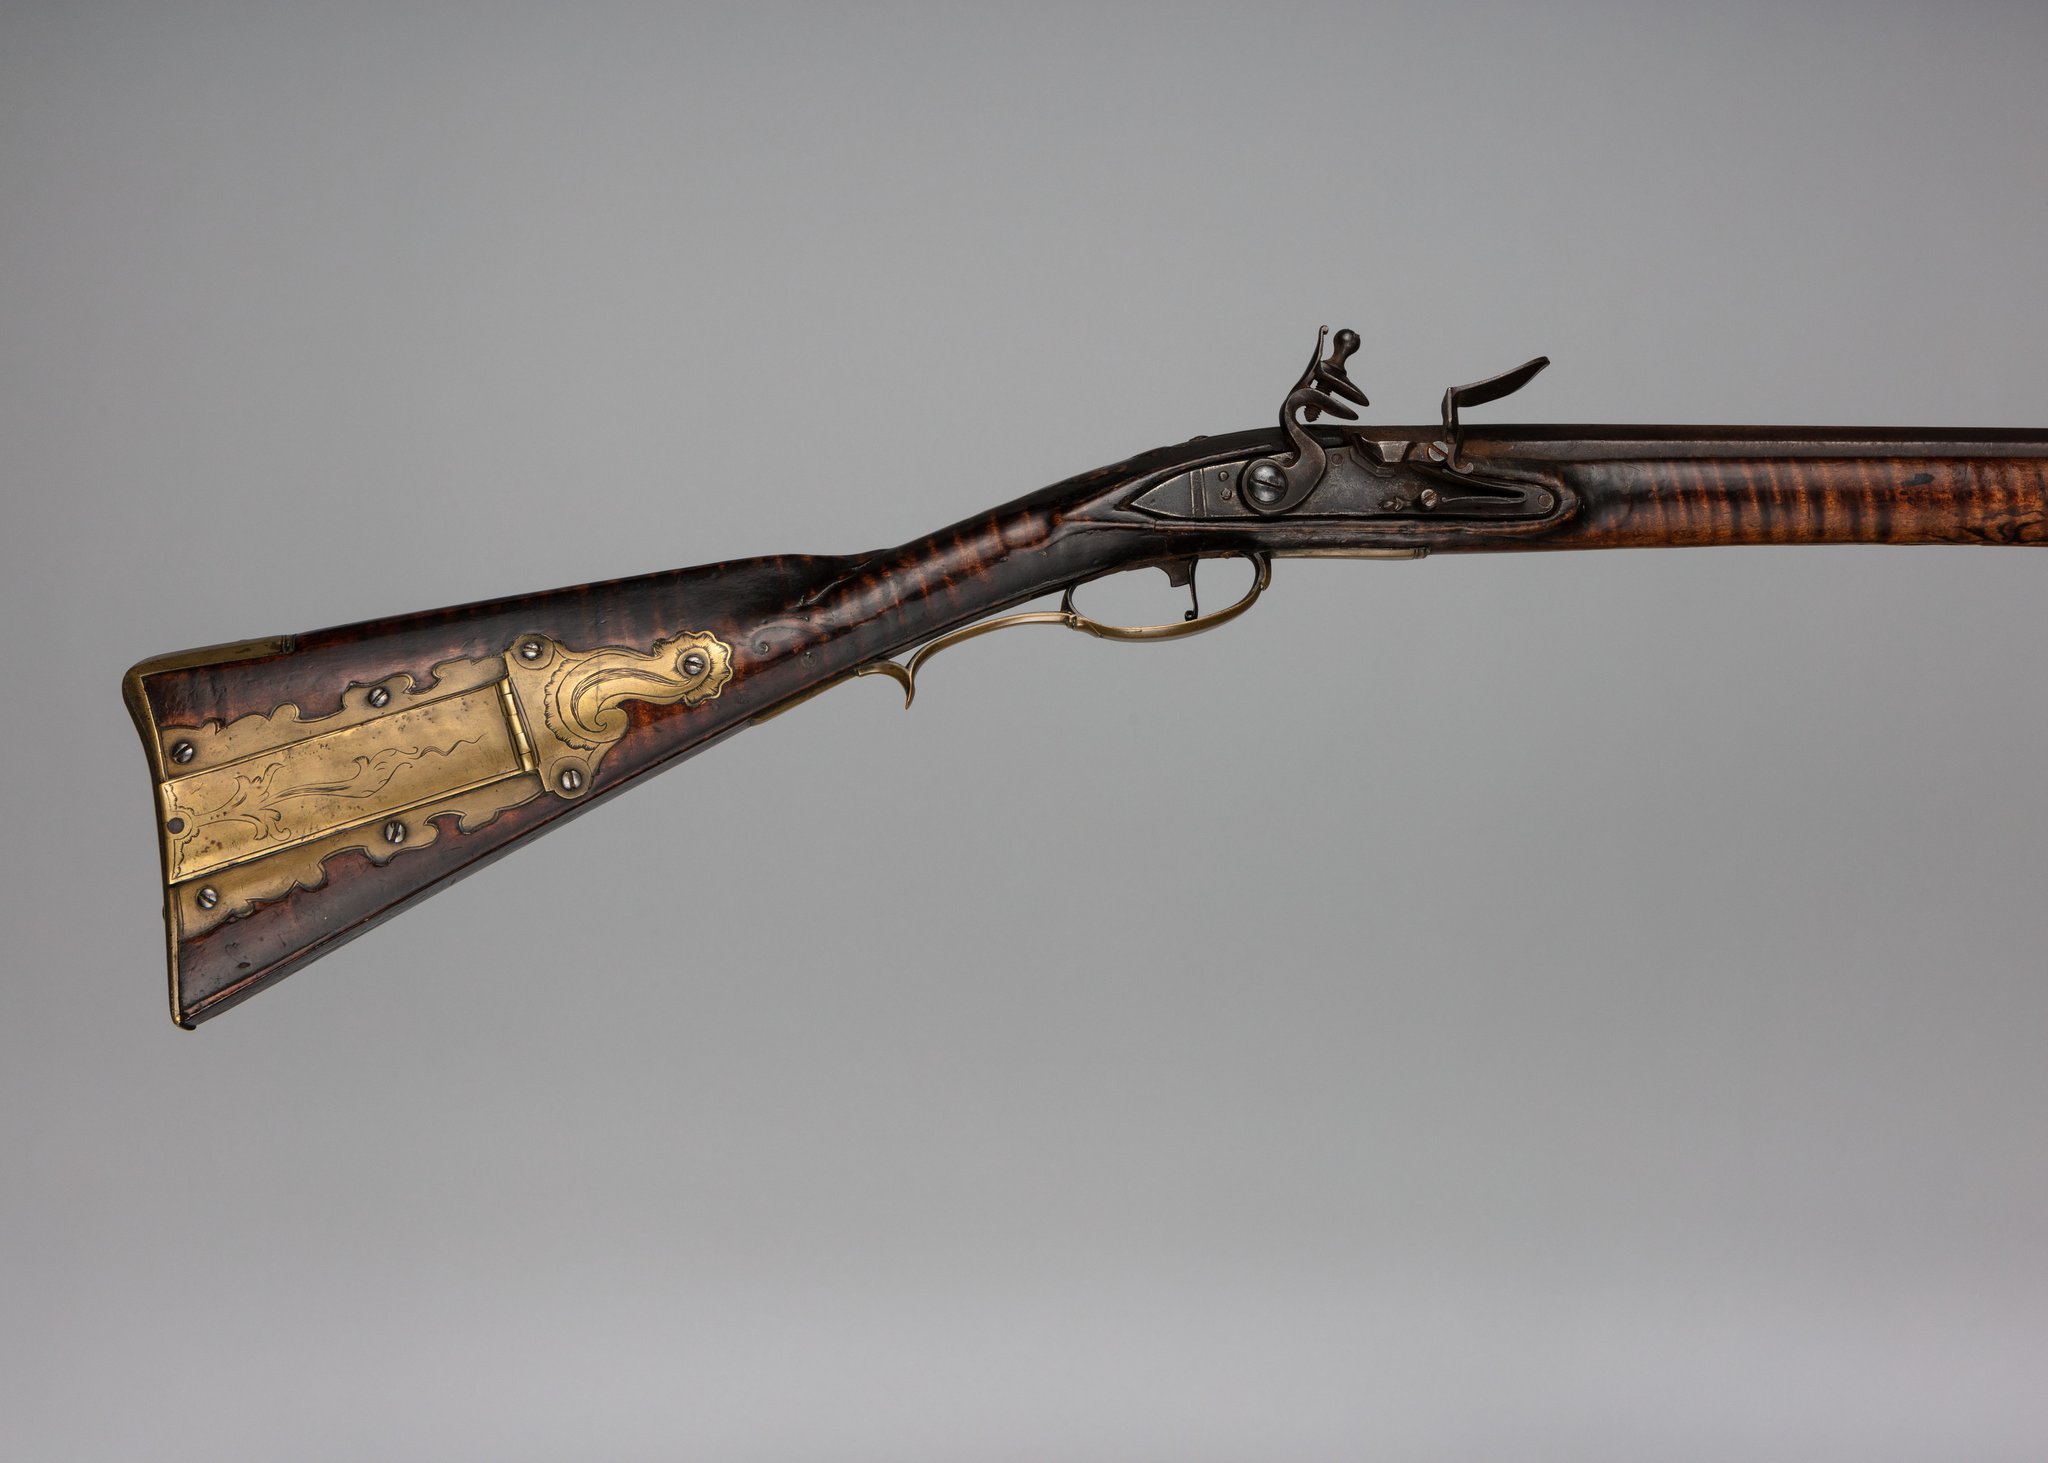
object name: flintlock longrifle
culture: american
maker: george schreyer, sr.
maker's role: gunsmith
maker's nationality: american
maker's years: 1739-1819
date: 1770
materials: brass, iron, steel, wood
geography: united states